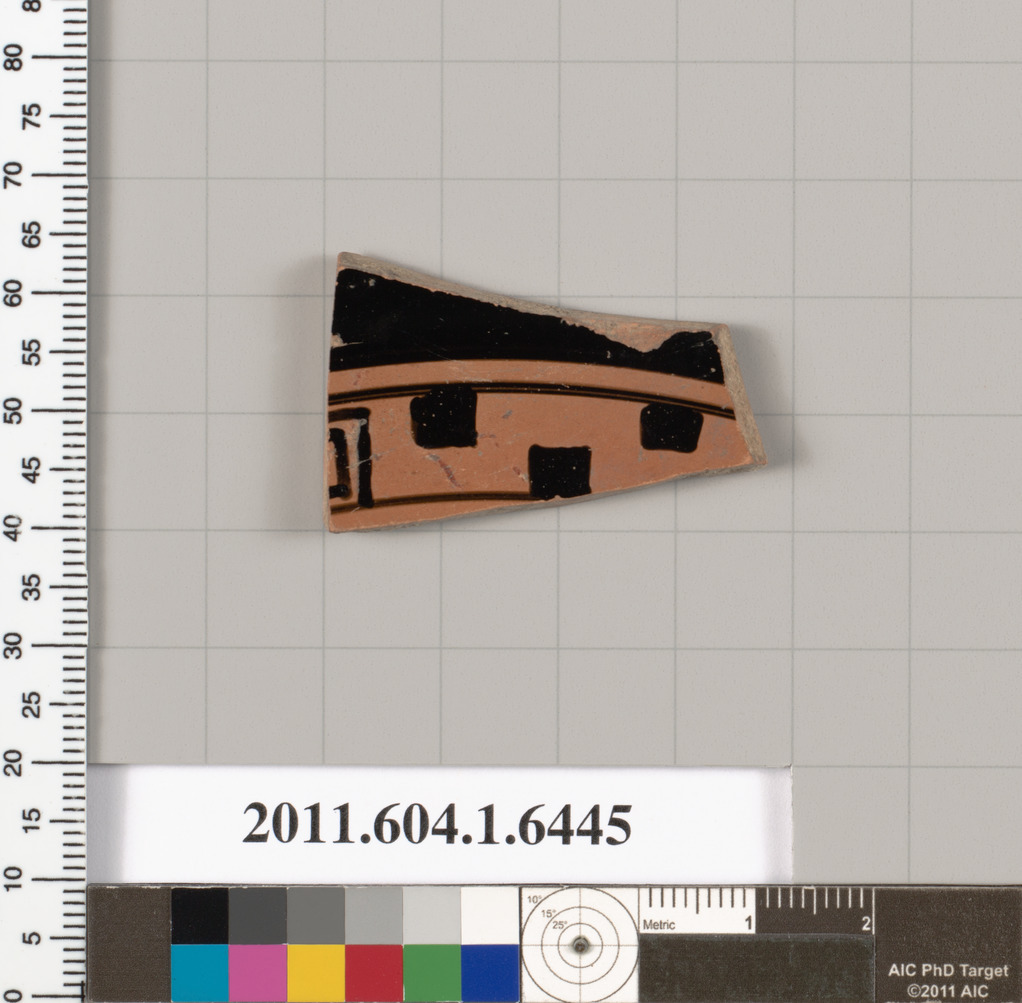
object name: kylix fragment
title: Terracotta fragment of a kylix (drinking cup)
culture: greek, attic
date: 490-480 BCE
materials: terracotta